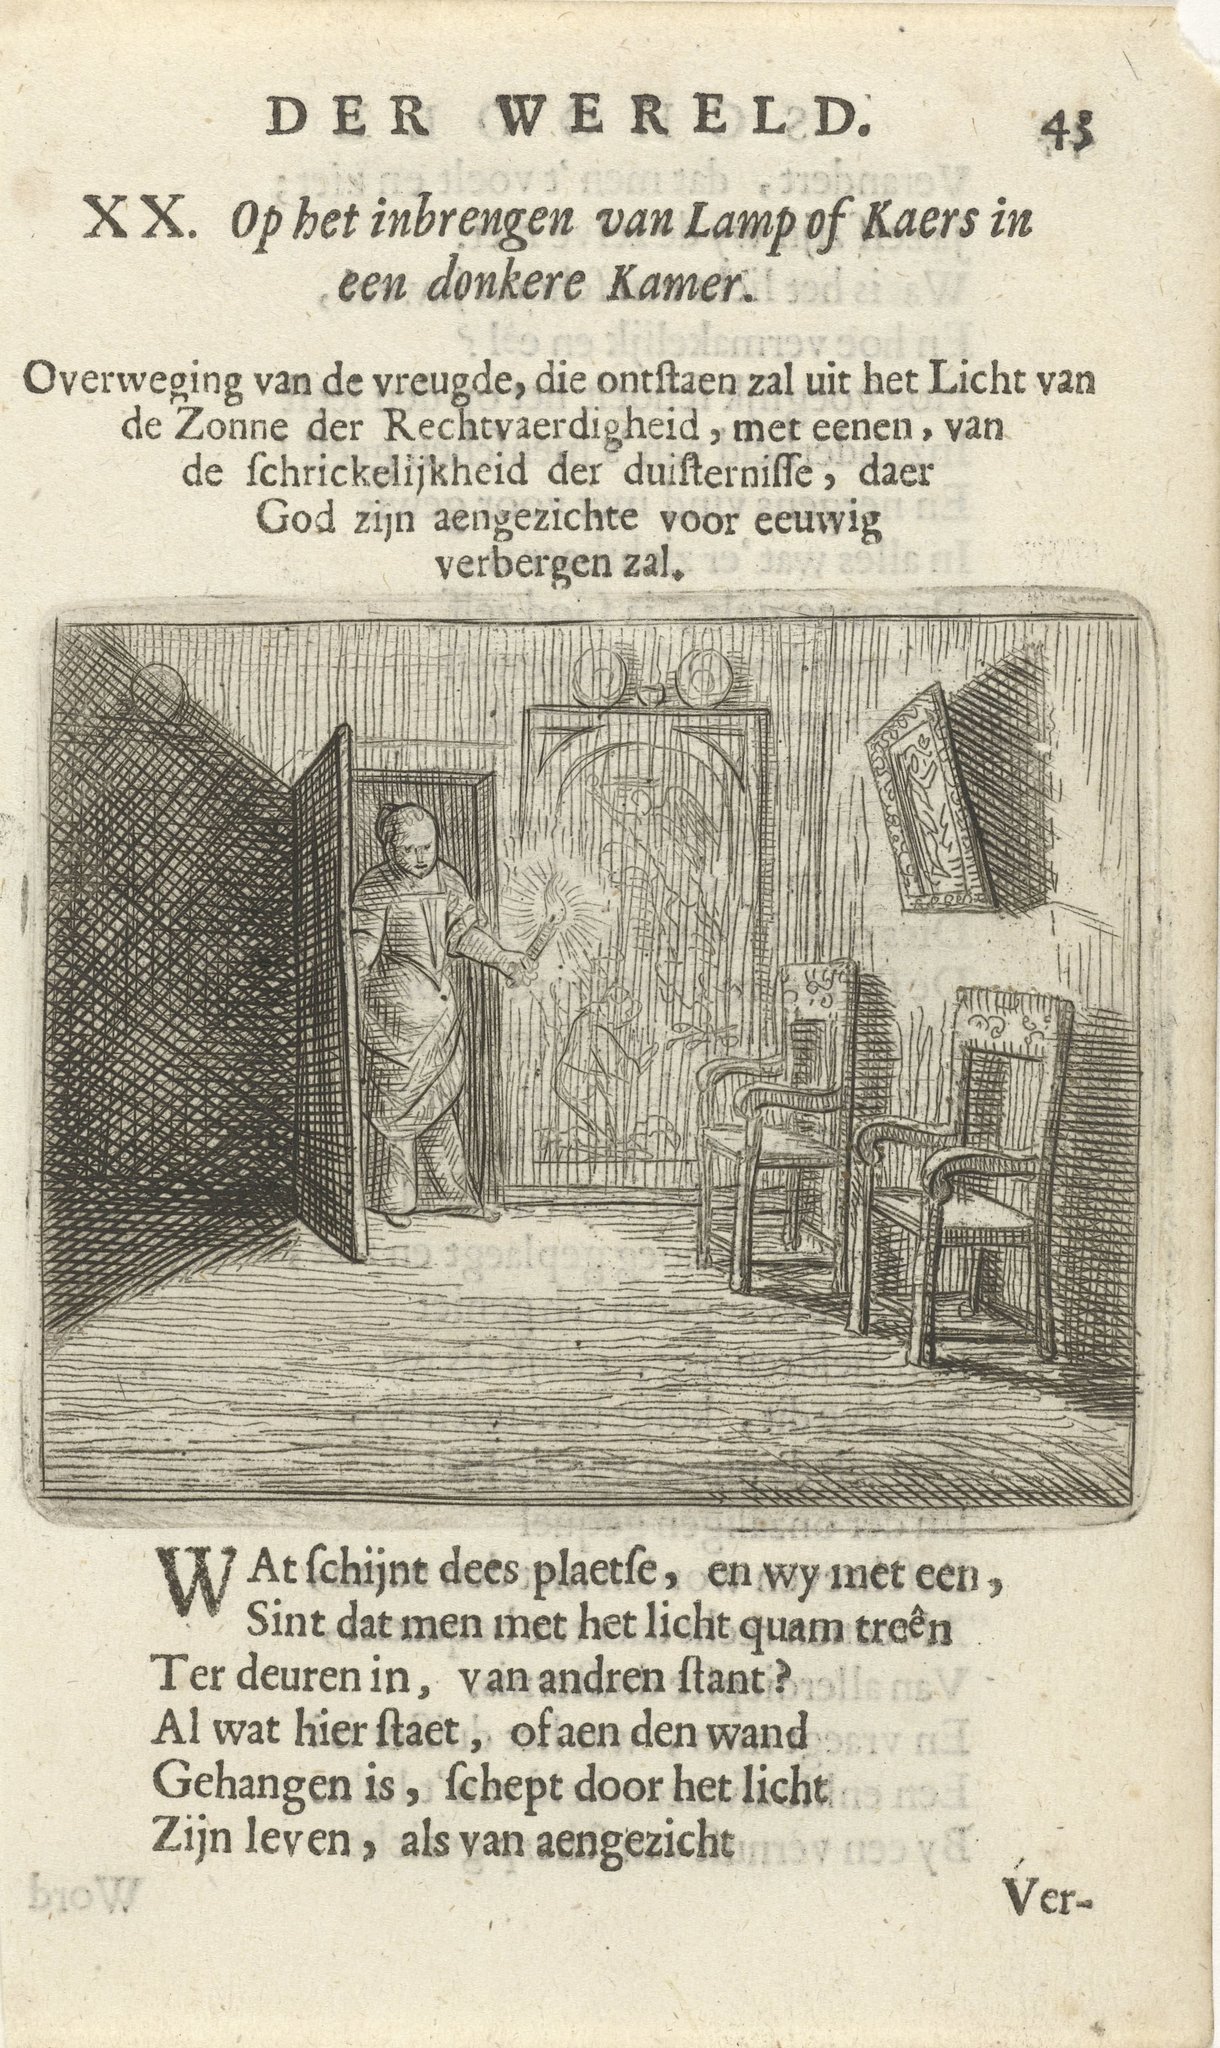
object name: print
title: XX. Op het inbrengen van Lamp of Kaers in een donkere Kamer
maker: arnold houbraken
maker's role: draughtsman, painter, print maker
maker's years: 1660-1719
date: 1682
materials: paper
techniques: etching, letterpress printing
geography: northern netherlands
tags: candle, darkness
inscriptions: collector's mark: Lugt 2228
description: Prent uit: Joseph Hall, [bewerkt door] François van Hoogstraeten, De schoole der wereld, geopent in CXL. vliegende bedenkingen op veelerhande voorvallende gezichten en zaeken. Dordrecht: François van Hoogstraeten, 1682. En in herdrukken in 1687 en 1725.